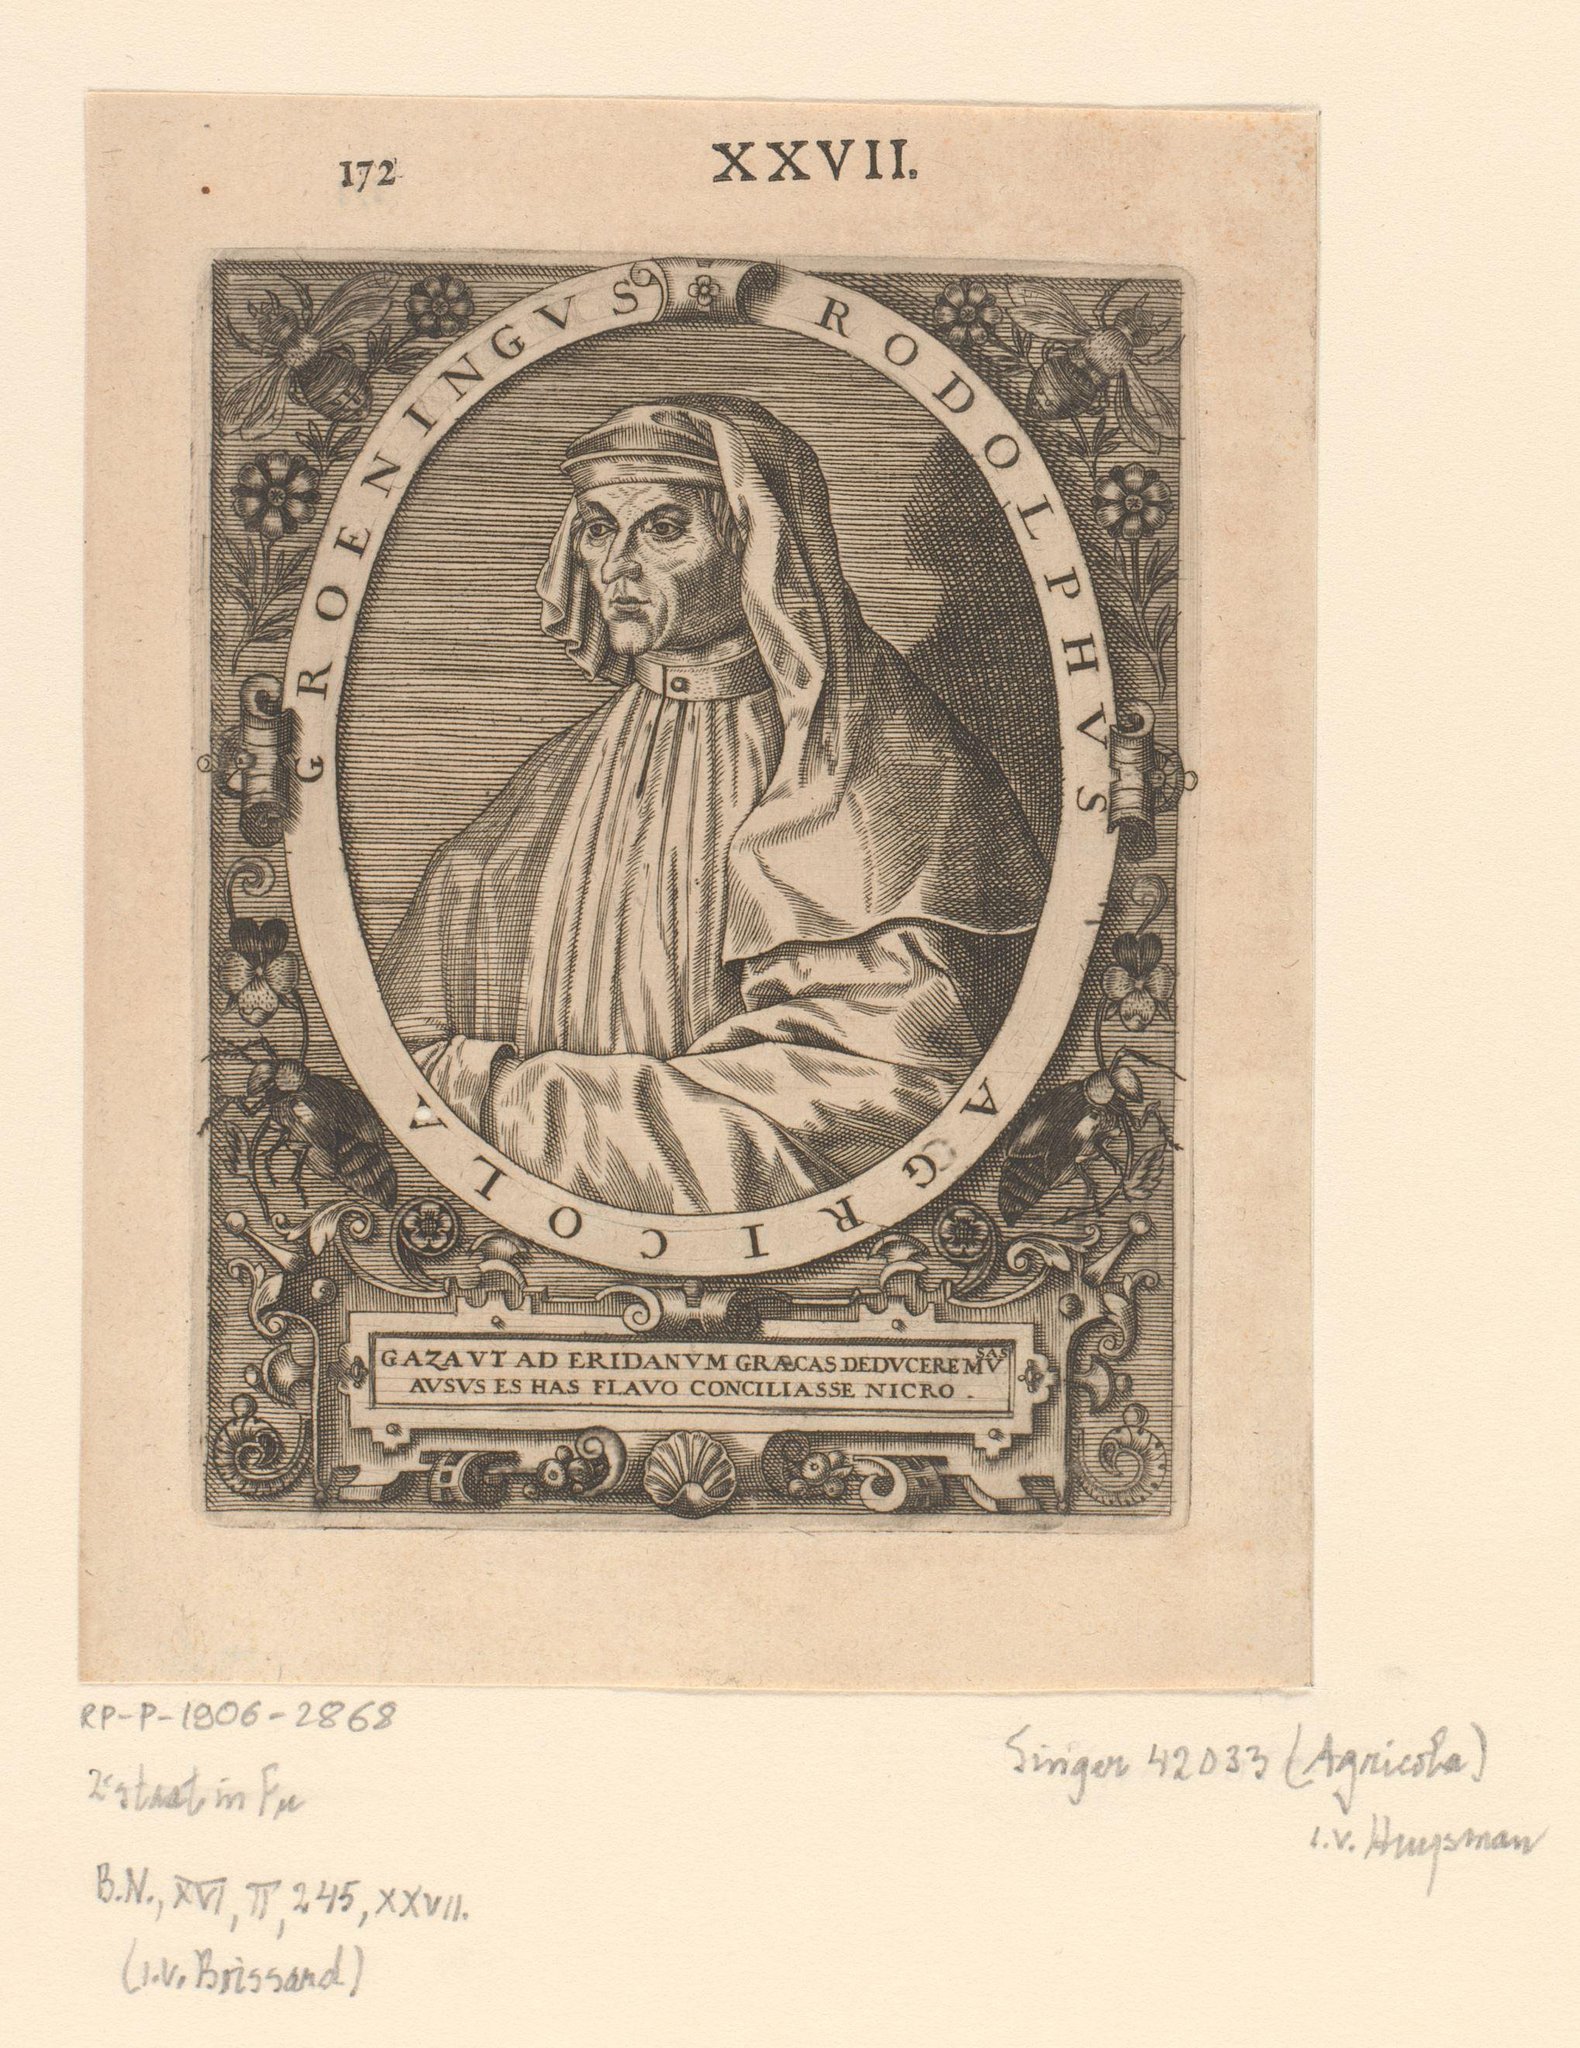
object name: book illustration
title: Rodolphus Agricola Groeningus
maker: jean jacques boissard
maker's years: 1528-1598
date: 1597-1599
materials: paper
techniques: engraving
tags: heidelberg, schrijver, rudolf agricola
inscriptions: collector's mark: Lugt 2228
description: Portret van de humanistische geleerde Rudolf Agricola, in ovaal met randschrift en een Latijns vers in een cartouche. In de sierlijst zijn bloemen en insecten verwerkt.